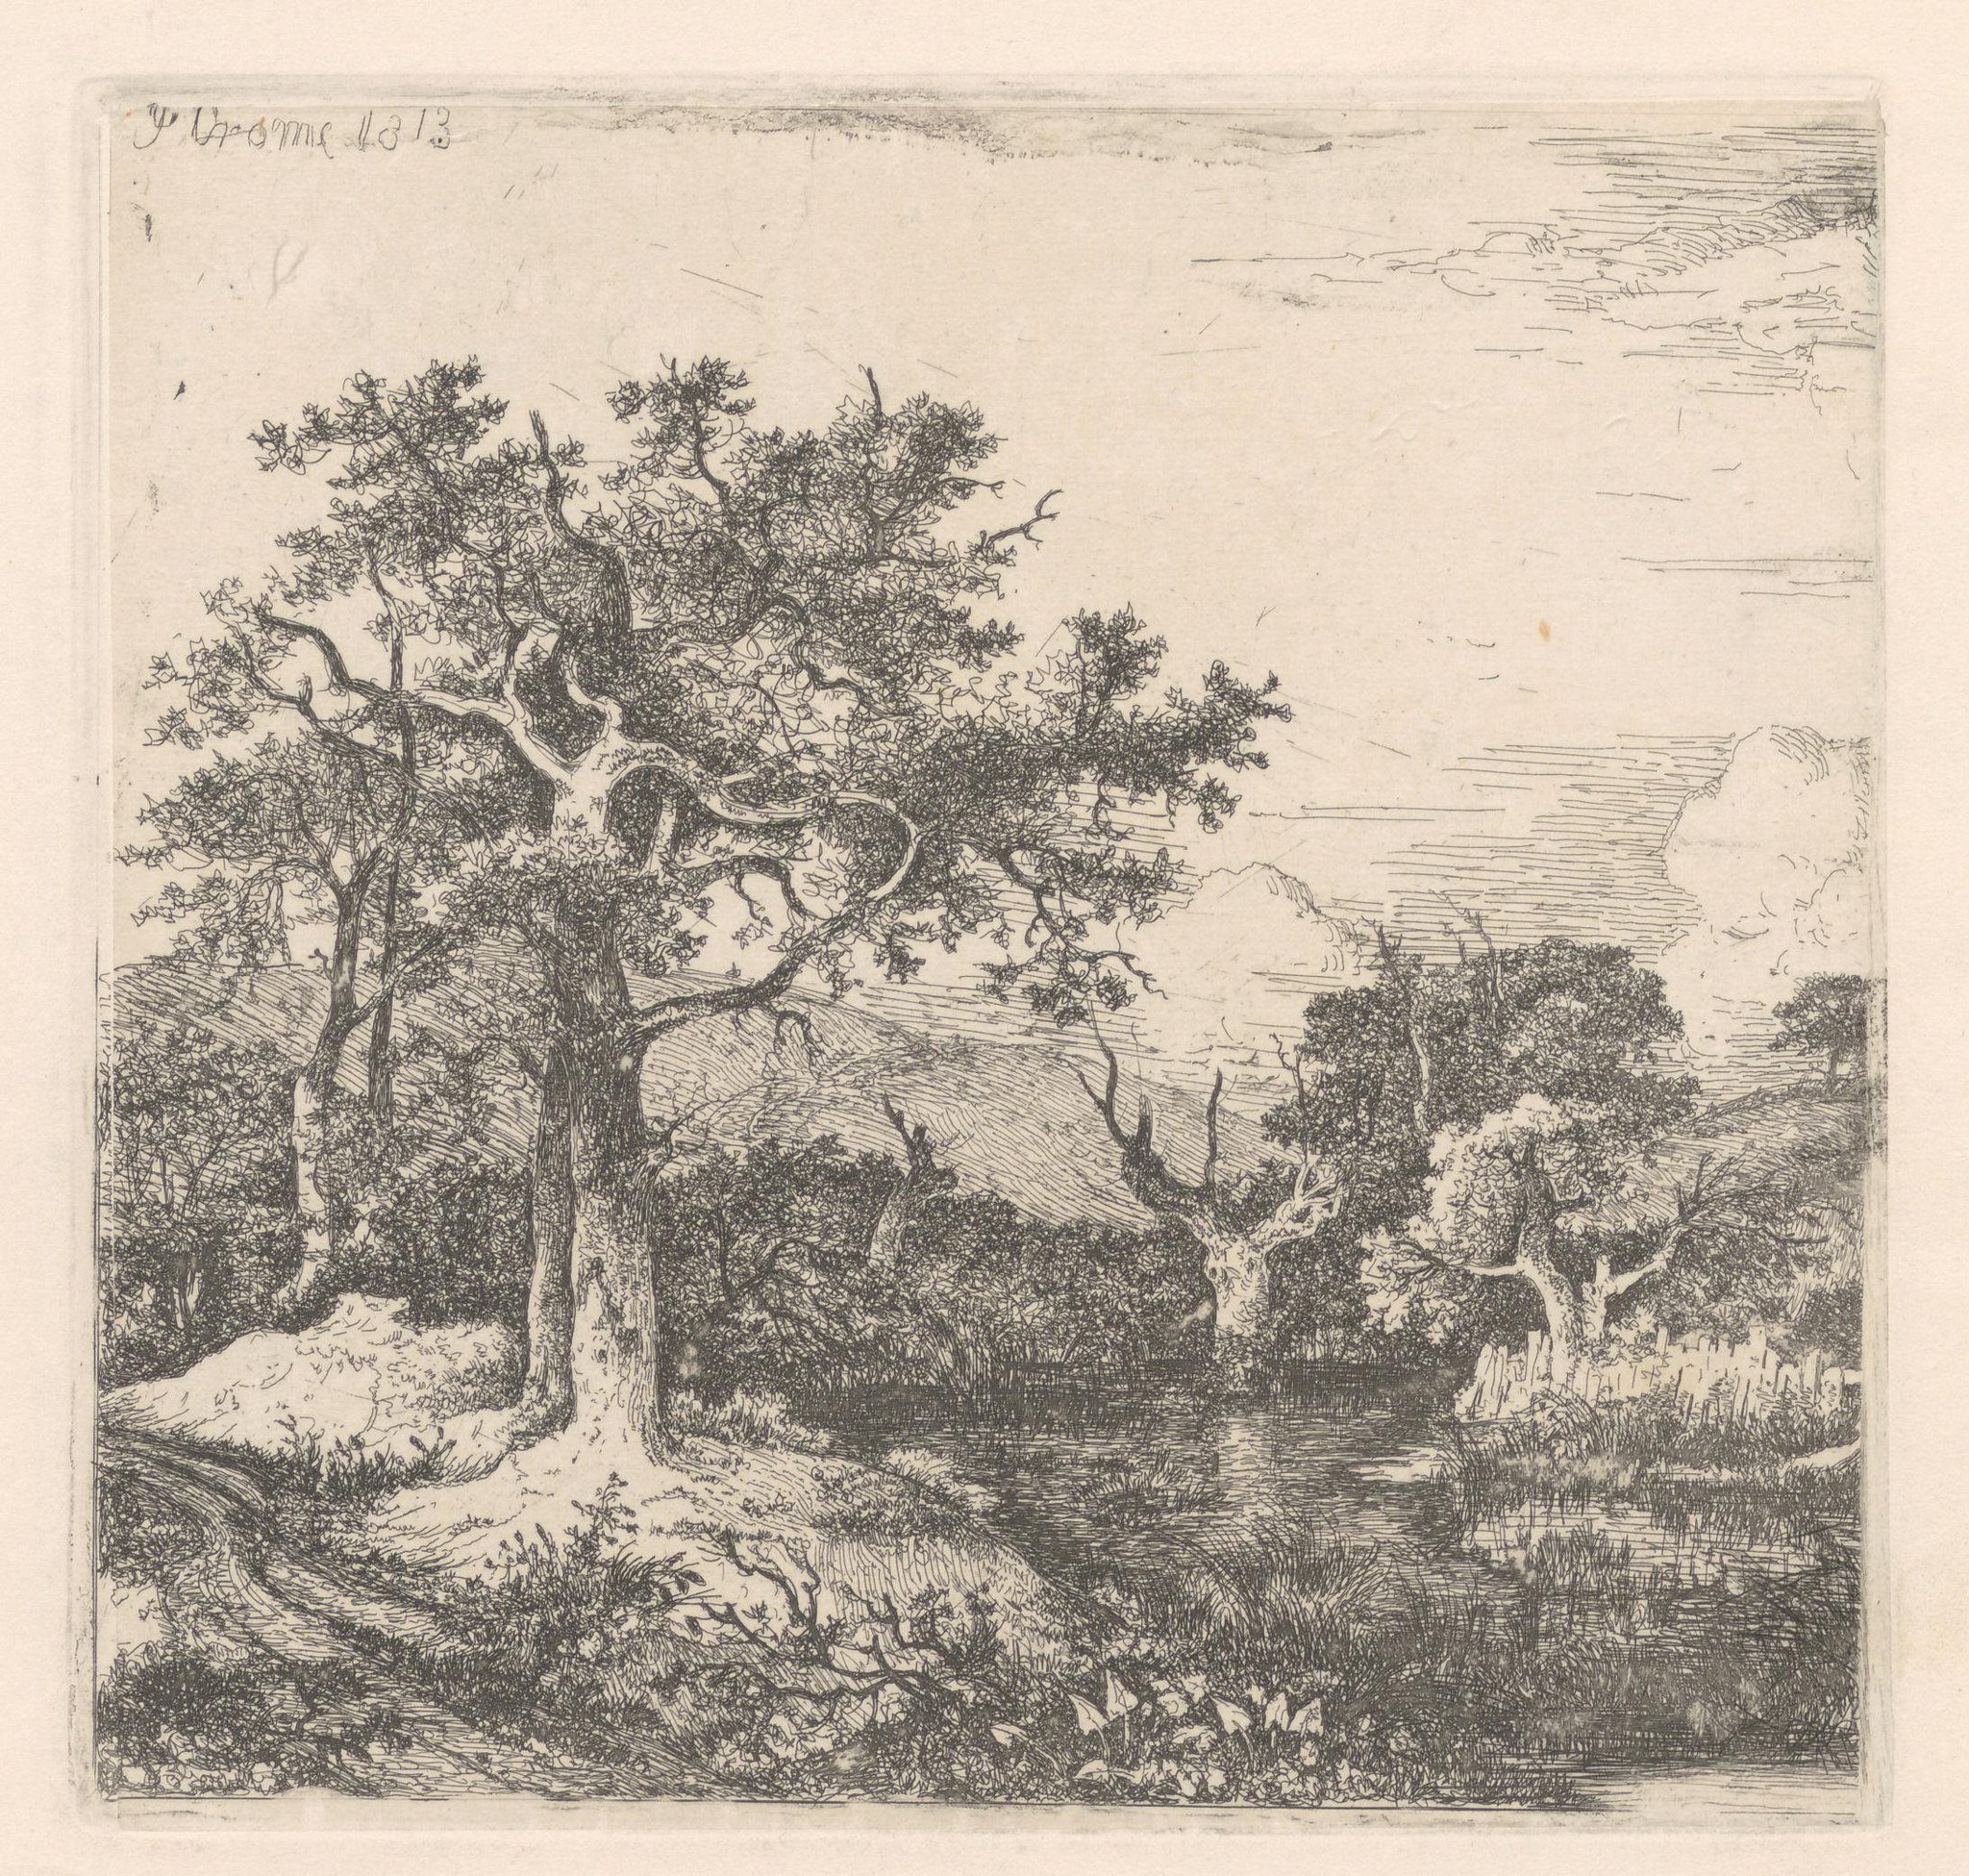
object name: print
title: Landschappen in Norfolk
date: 1813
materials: paper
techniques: etching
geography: norwich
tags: trees, pool, puddle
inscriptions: collector's mark: Lugt 2760, collector's mark: Lugt 2228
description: Prent staat samen met RP-P-1973-196 op een onversneden blad.